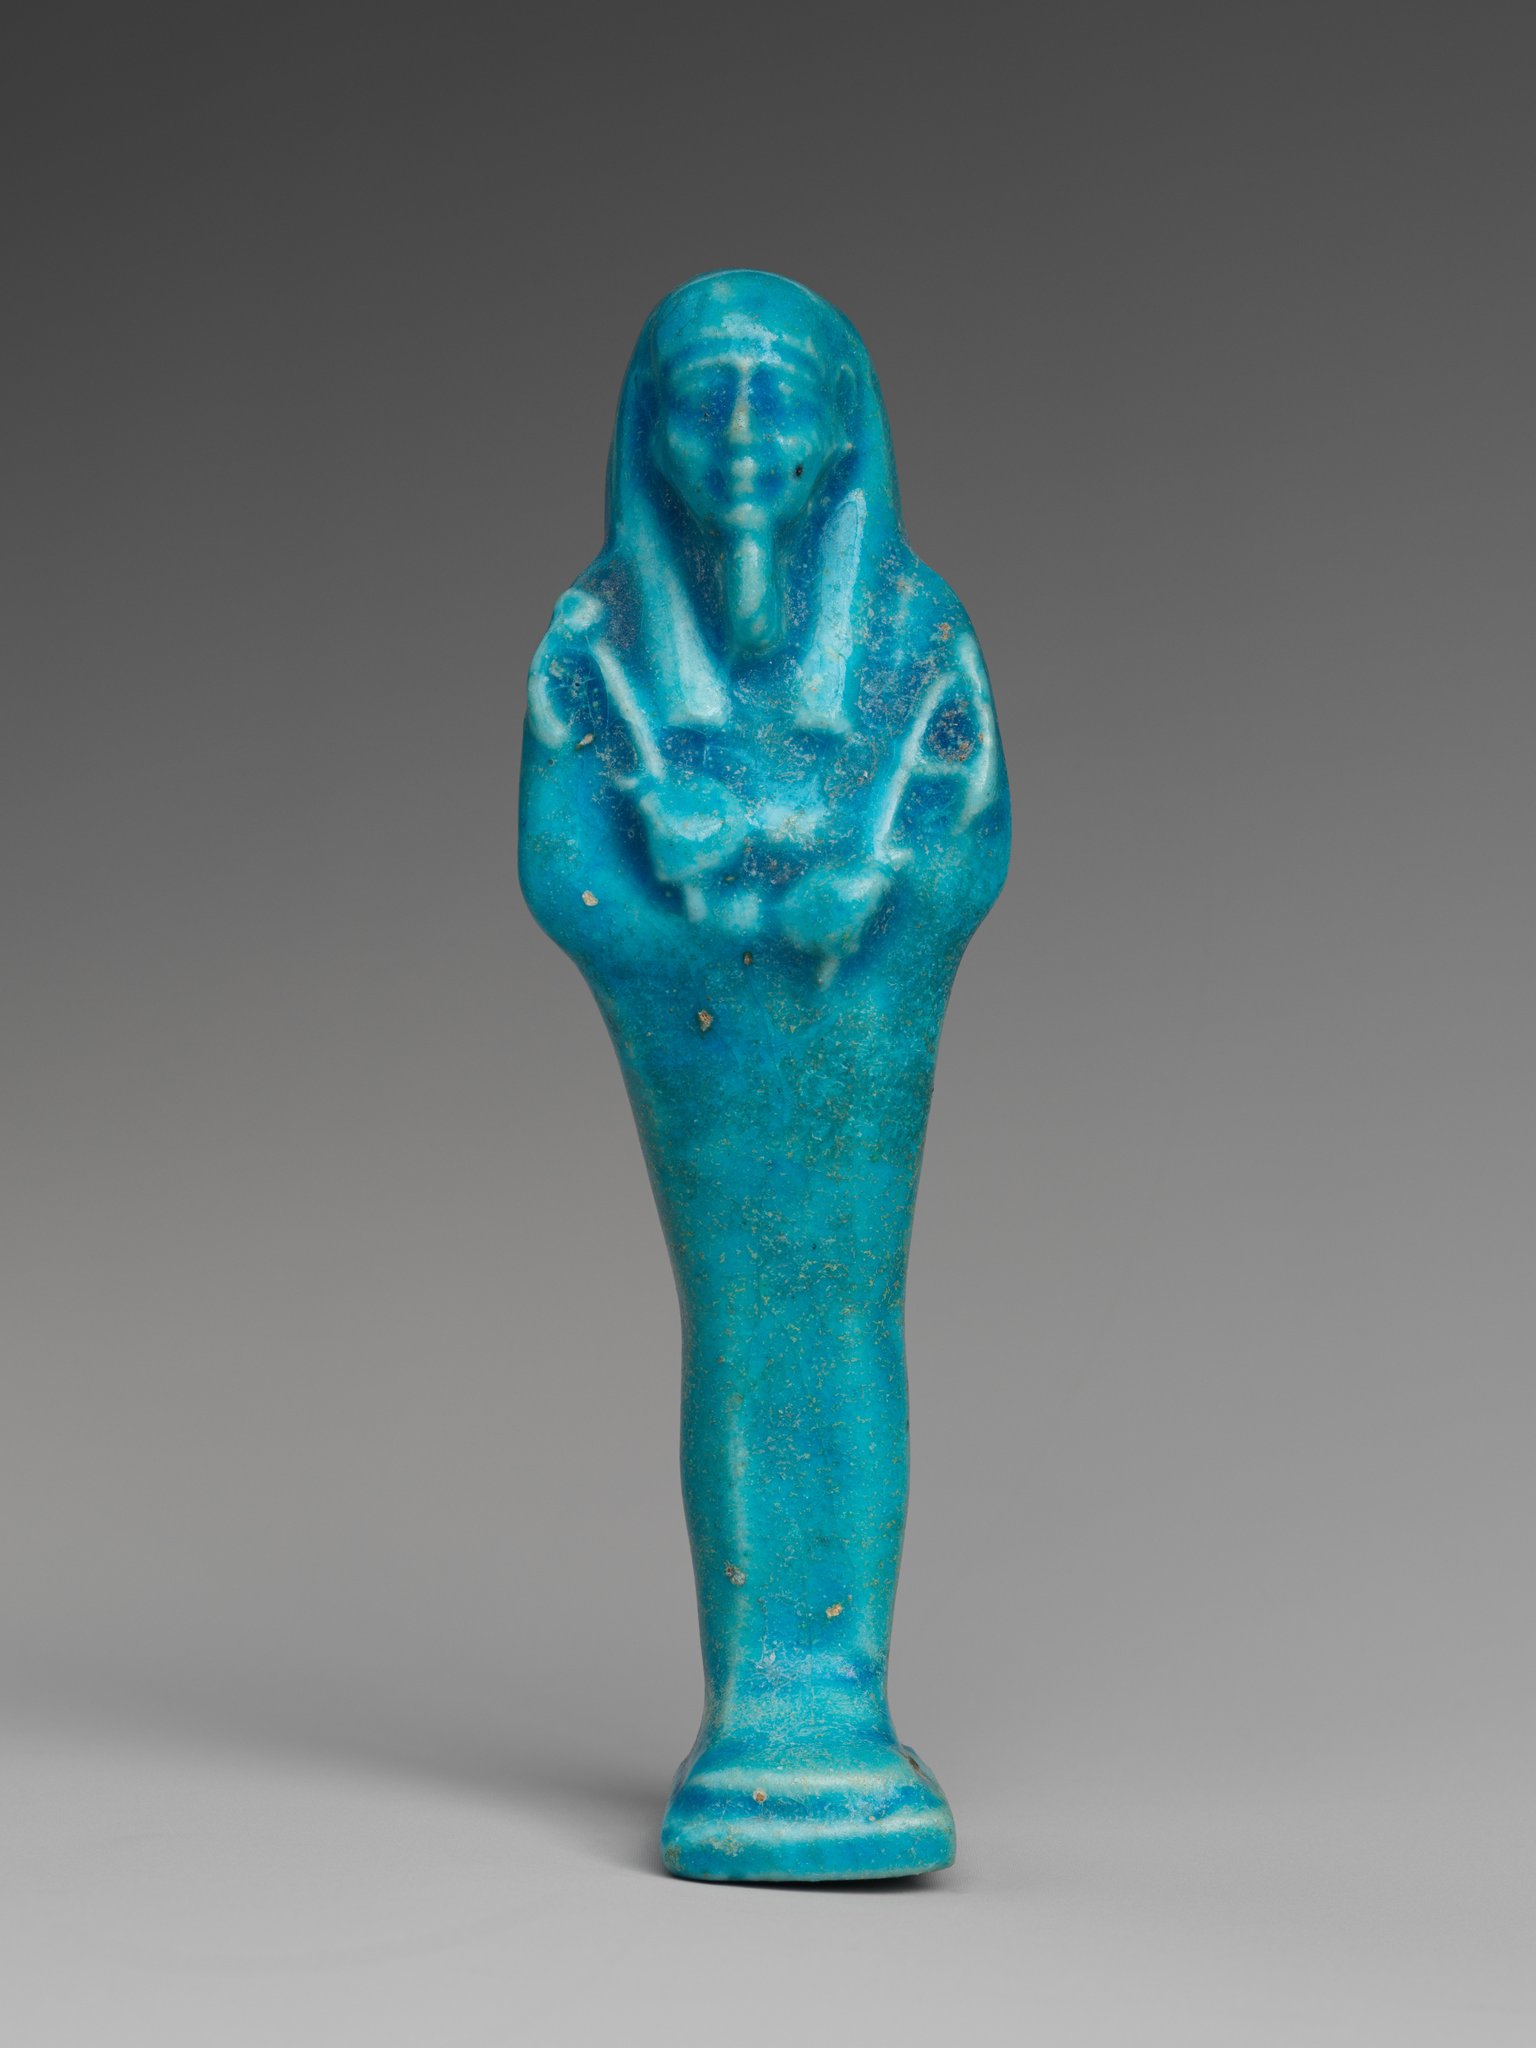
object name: shabti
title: Shabti of Petosiris, son of Djedhor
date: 360-300 BCE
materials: faience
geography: egypt